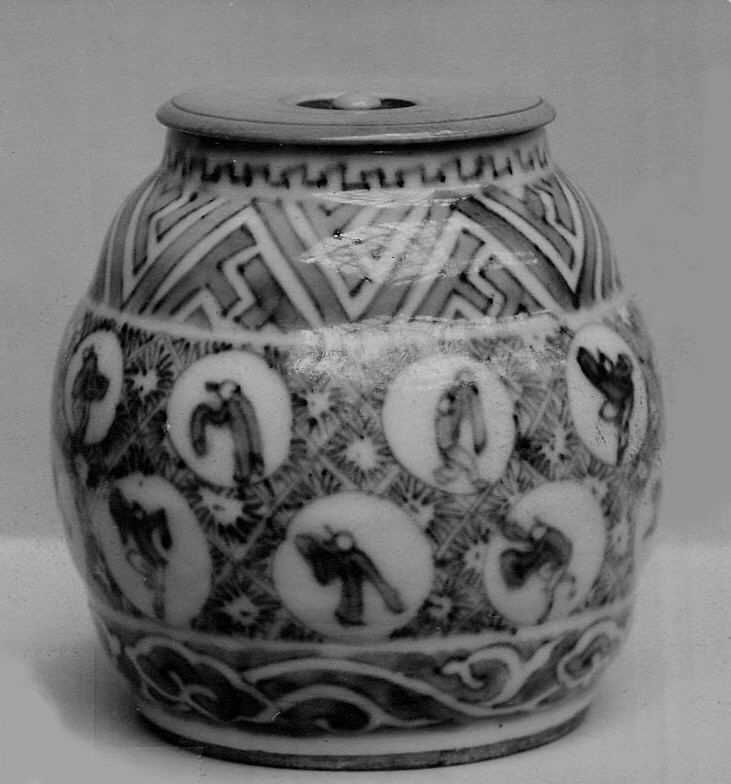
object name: tea jar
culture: japanese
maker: gorodayu shonzui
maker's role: artist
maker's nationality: japanese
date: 1501-1533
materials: glaze, porcelain